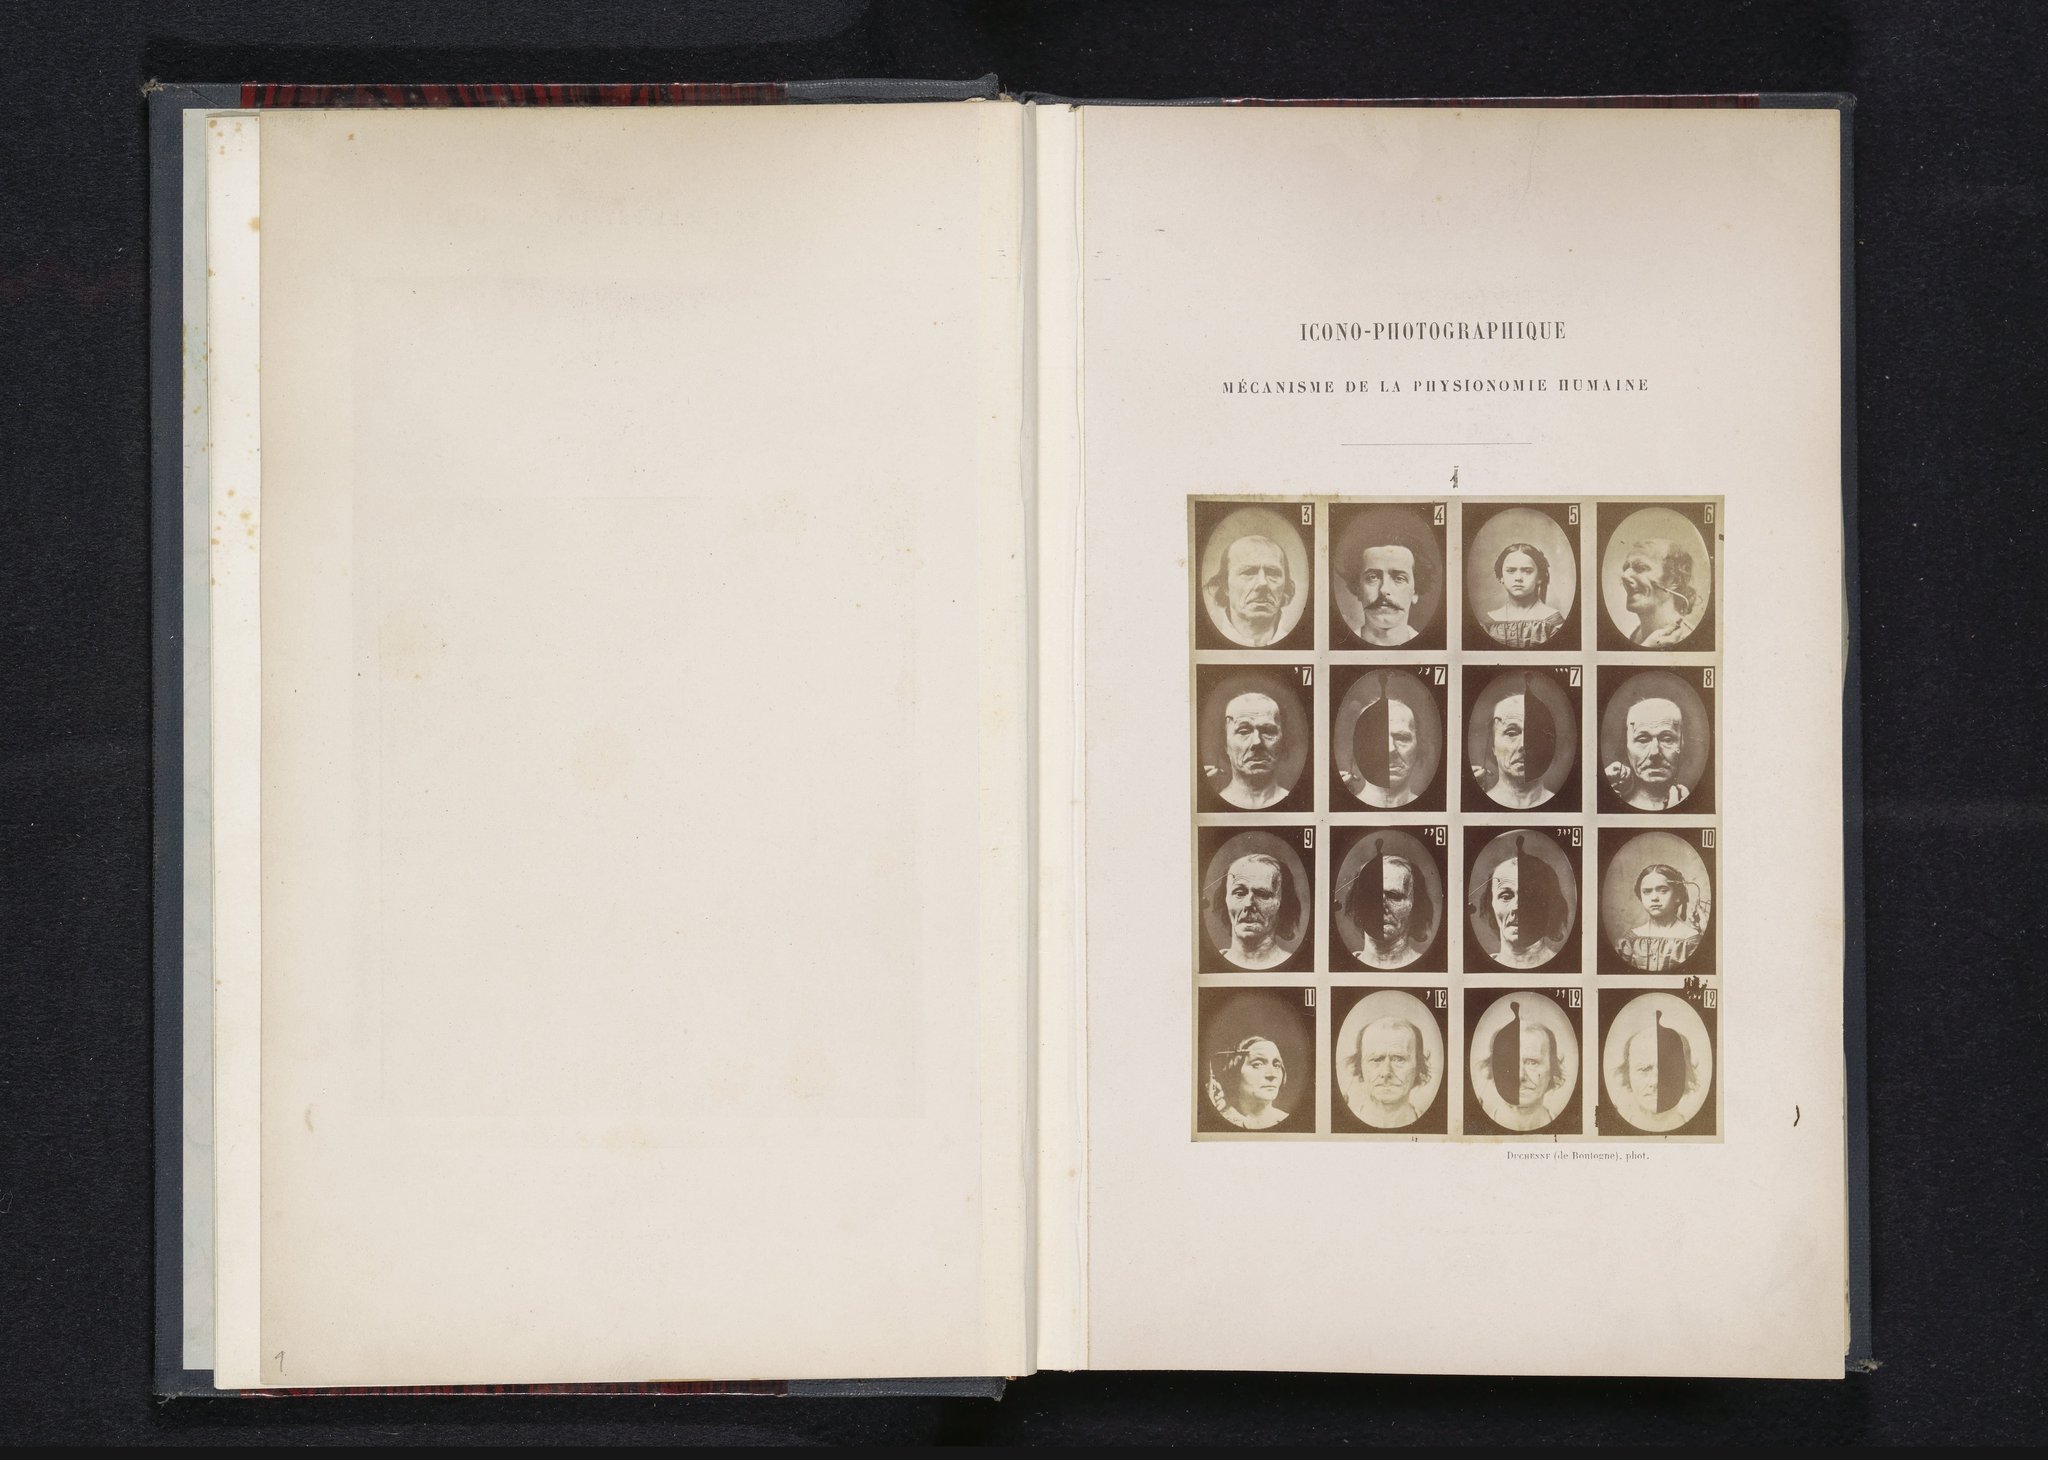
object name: photograph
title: Icono-Photographique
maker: guillaume benjamin amand duchenne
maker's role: fotograaf, medicus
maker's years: 1806-1875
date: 1860-1862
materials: paper, photographic support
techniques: albumen print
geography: paris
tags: face, adult woman, physiology and anatomy ~ nervous system, neurology, adult man, child, physiology and anatomy, old man, morphology of facial expression, physiognomy, experiment, test ~ science and technology, france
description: Ongenummerde pagina met foto 1 uit Mécanisme de la physionomie humaine ou analyse électro-physiologique de l'expression des passions (Atlas).